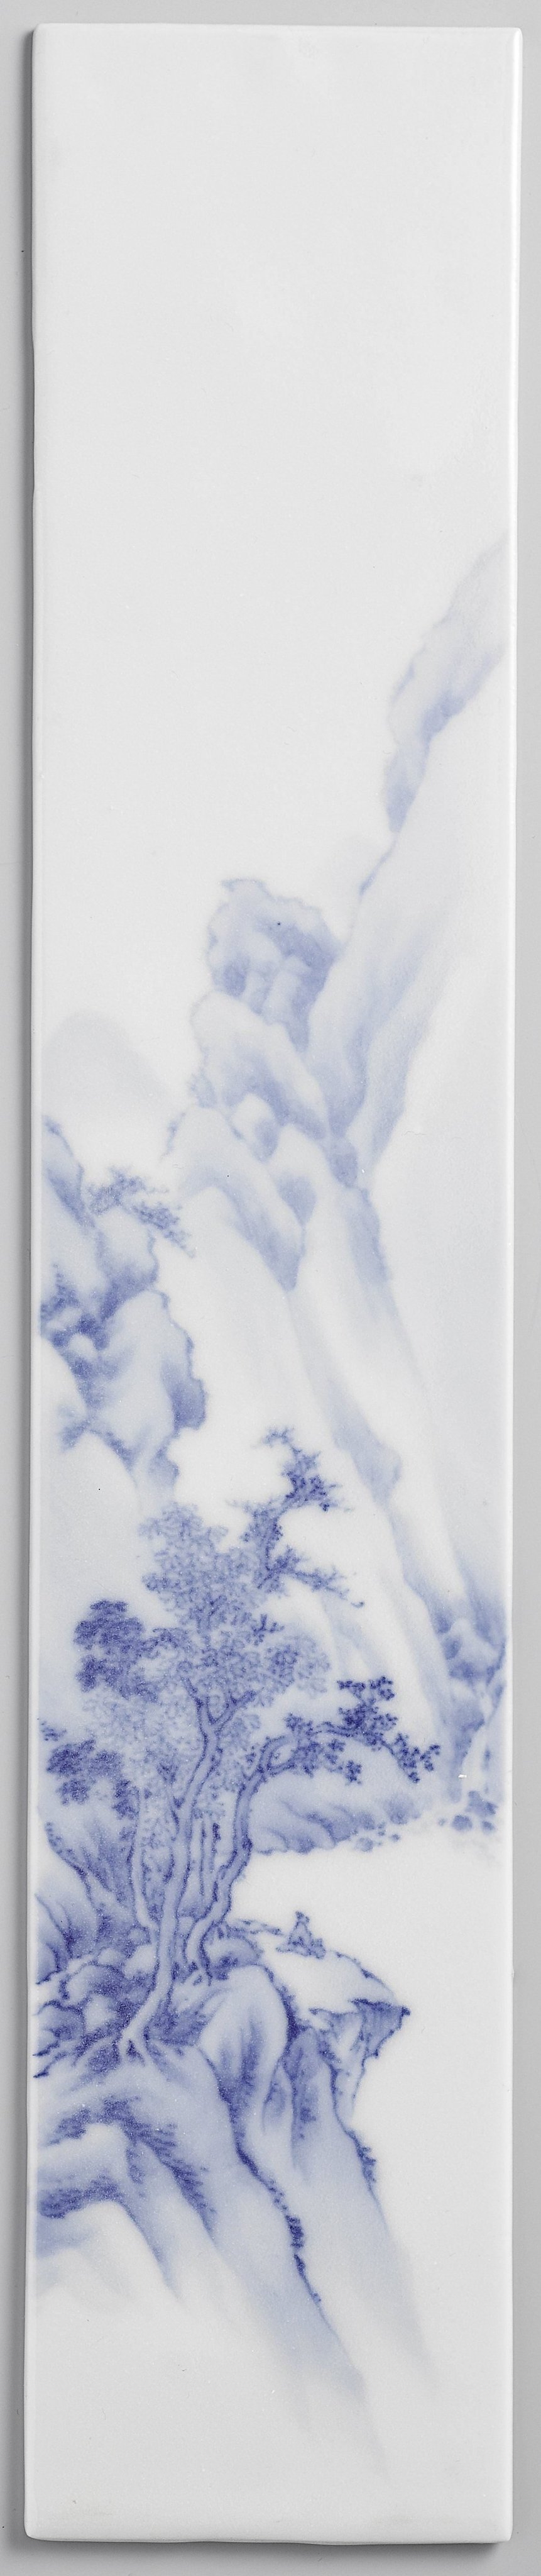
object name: plaque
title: Plaque with a water landscape with seated figure, trees and mountains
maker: Anonymous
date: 1900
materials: cobalt, glaze, paint, porcelain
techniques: firing, vitrification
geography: japan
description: Rechthoekige plaque van porselein, beschilderd in onderglazuur blauw. Op de voorzijde een zittend persoon aan de rand van een klif, achter hem bomen. In de achtergrond een bergpartij. Blauw-wit.